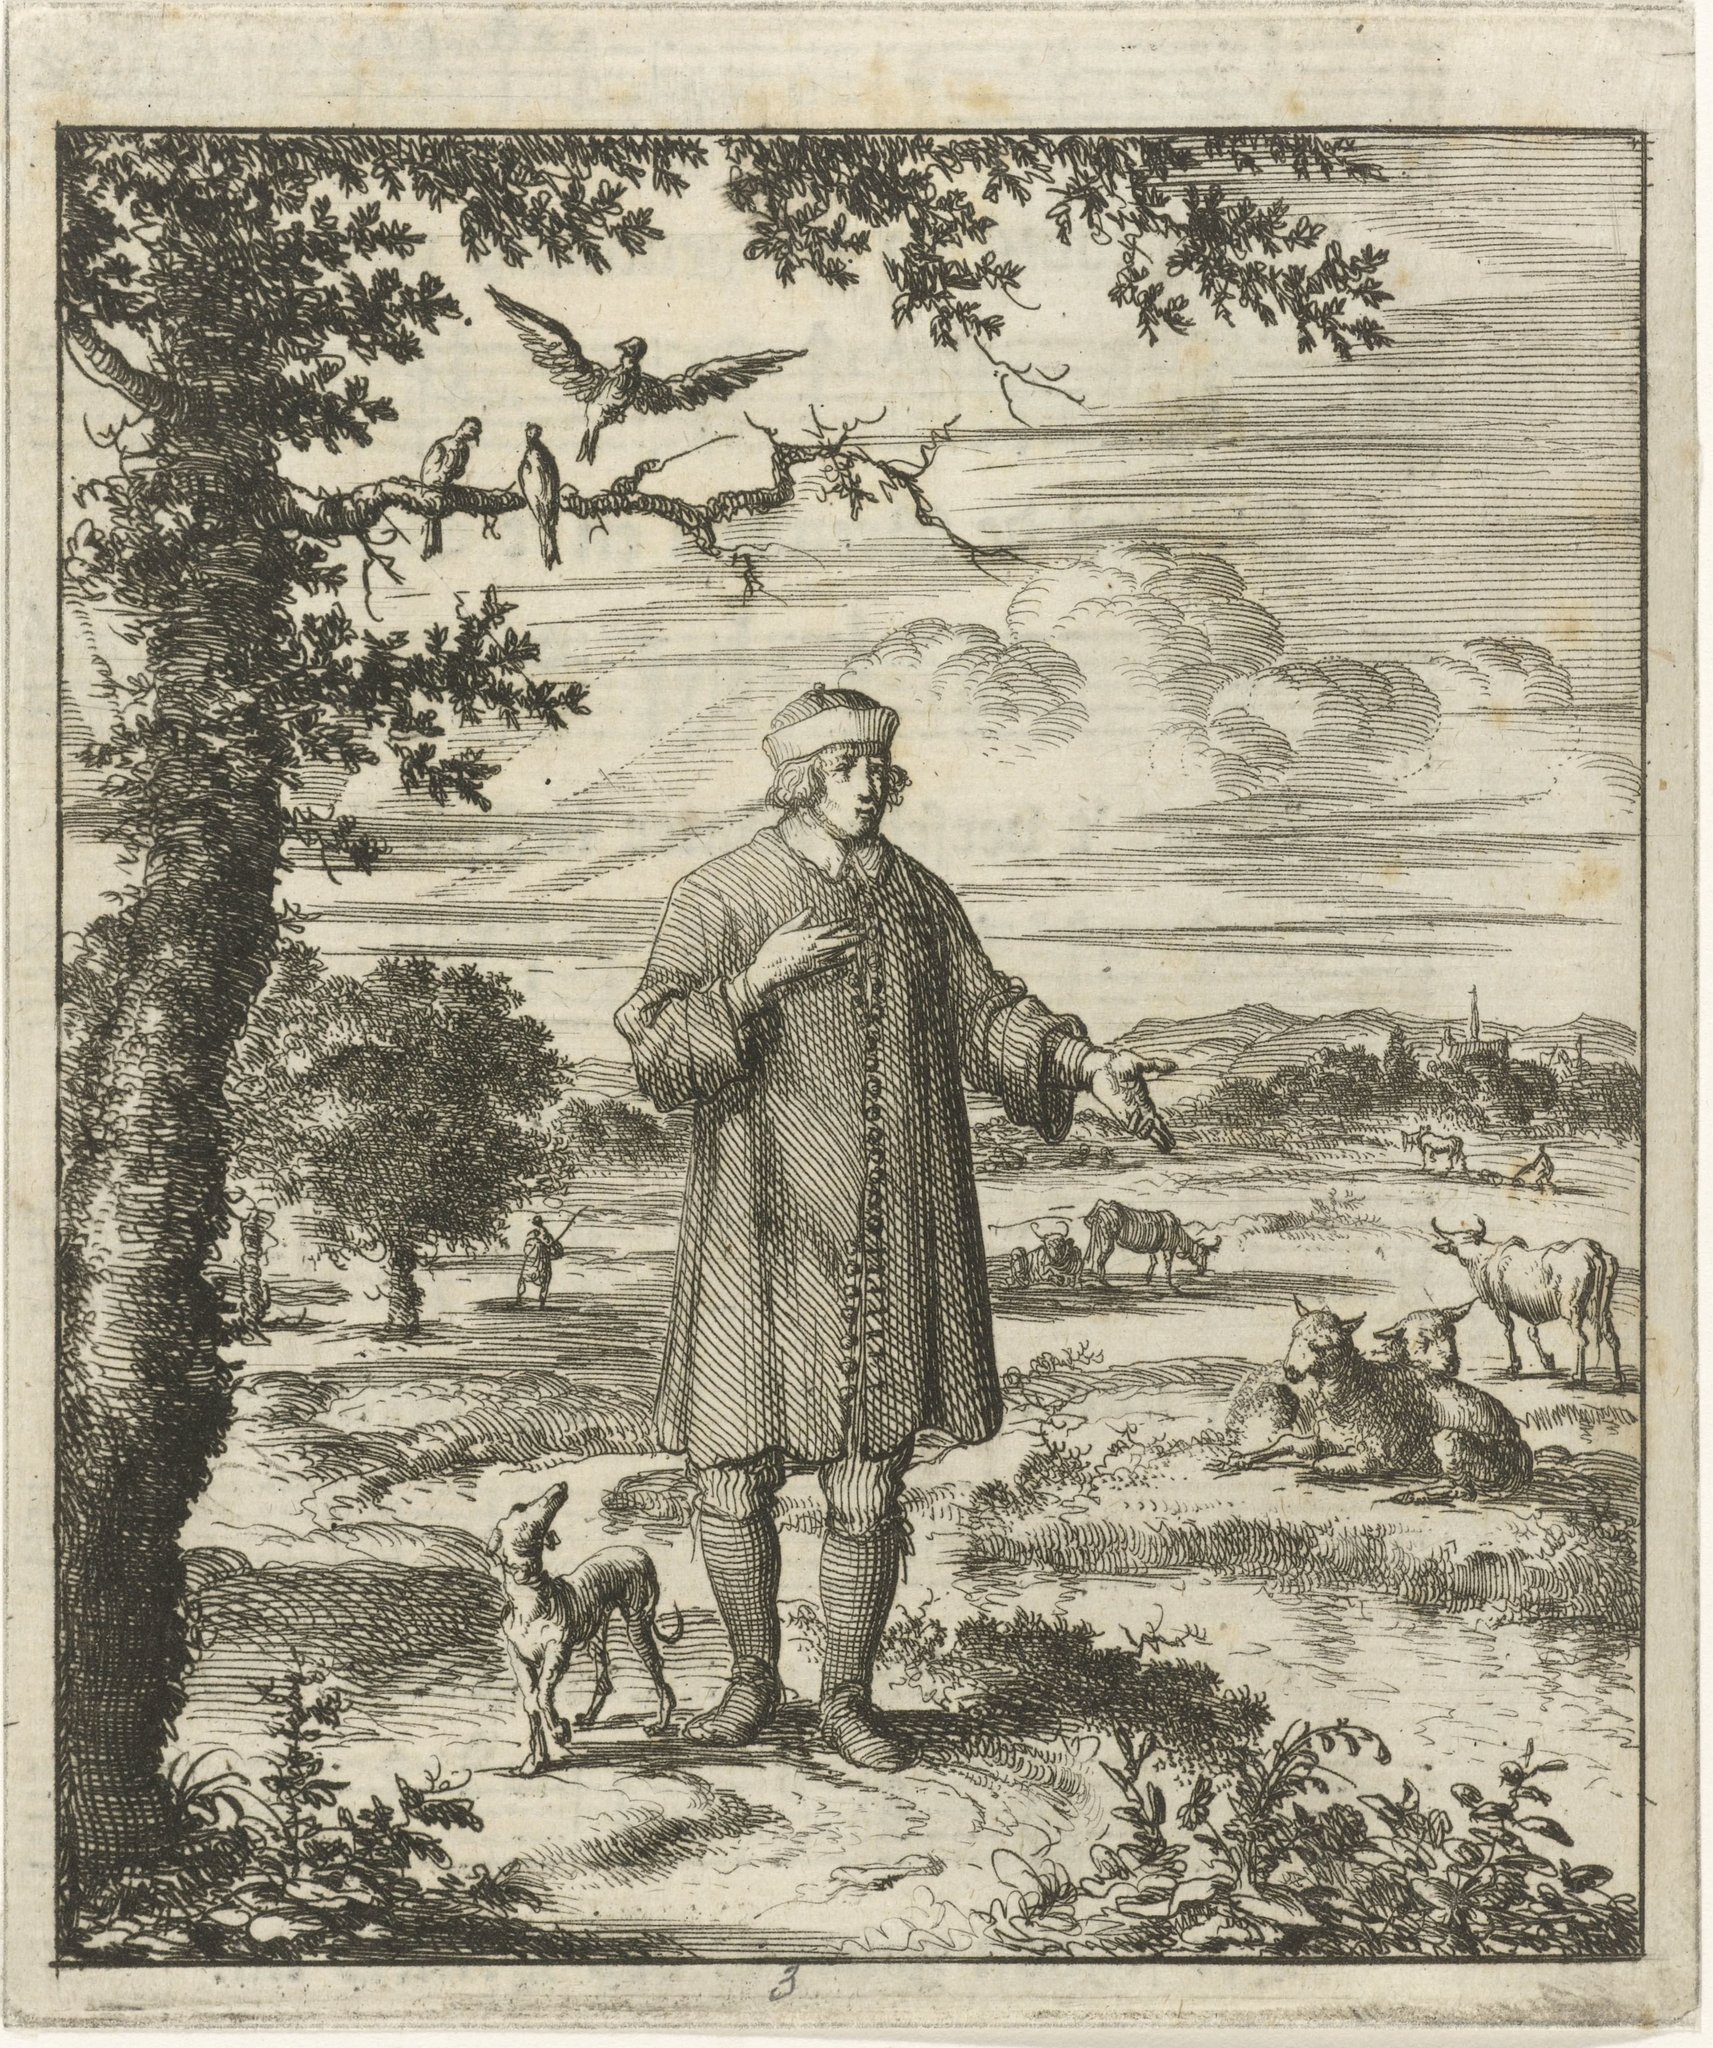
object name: book illustration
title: Schrijver Willem Sluiter met een hond bij een beek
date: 1687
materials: paper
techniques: etching, letterpress printing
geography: amsterdam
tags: spring, source of river or stream, dog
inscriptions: collector's mark: Lugt 2228, number: ‘3’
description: Illustratie uit: Sluiter, Willem. Buiten- eensaem huis- somer- en winter-leven. Amsterdam: Gerbrandt Schagen, 1687, p. 11.